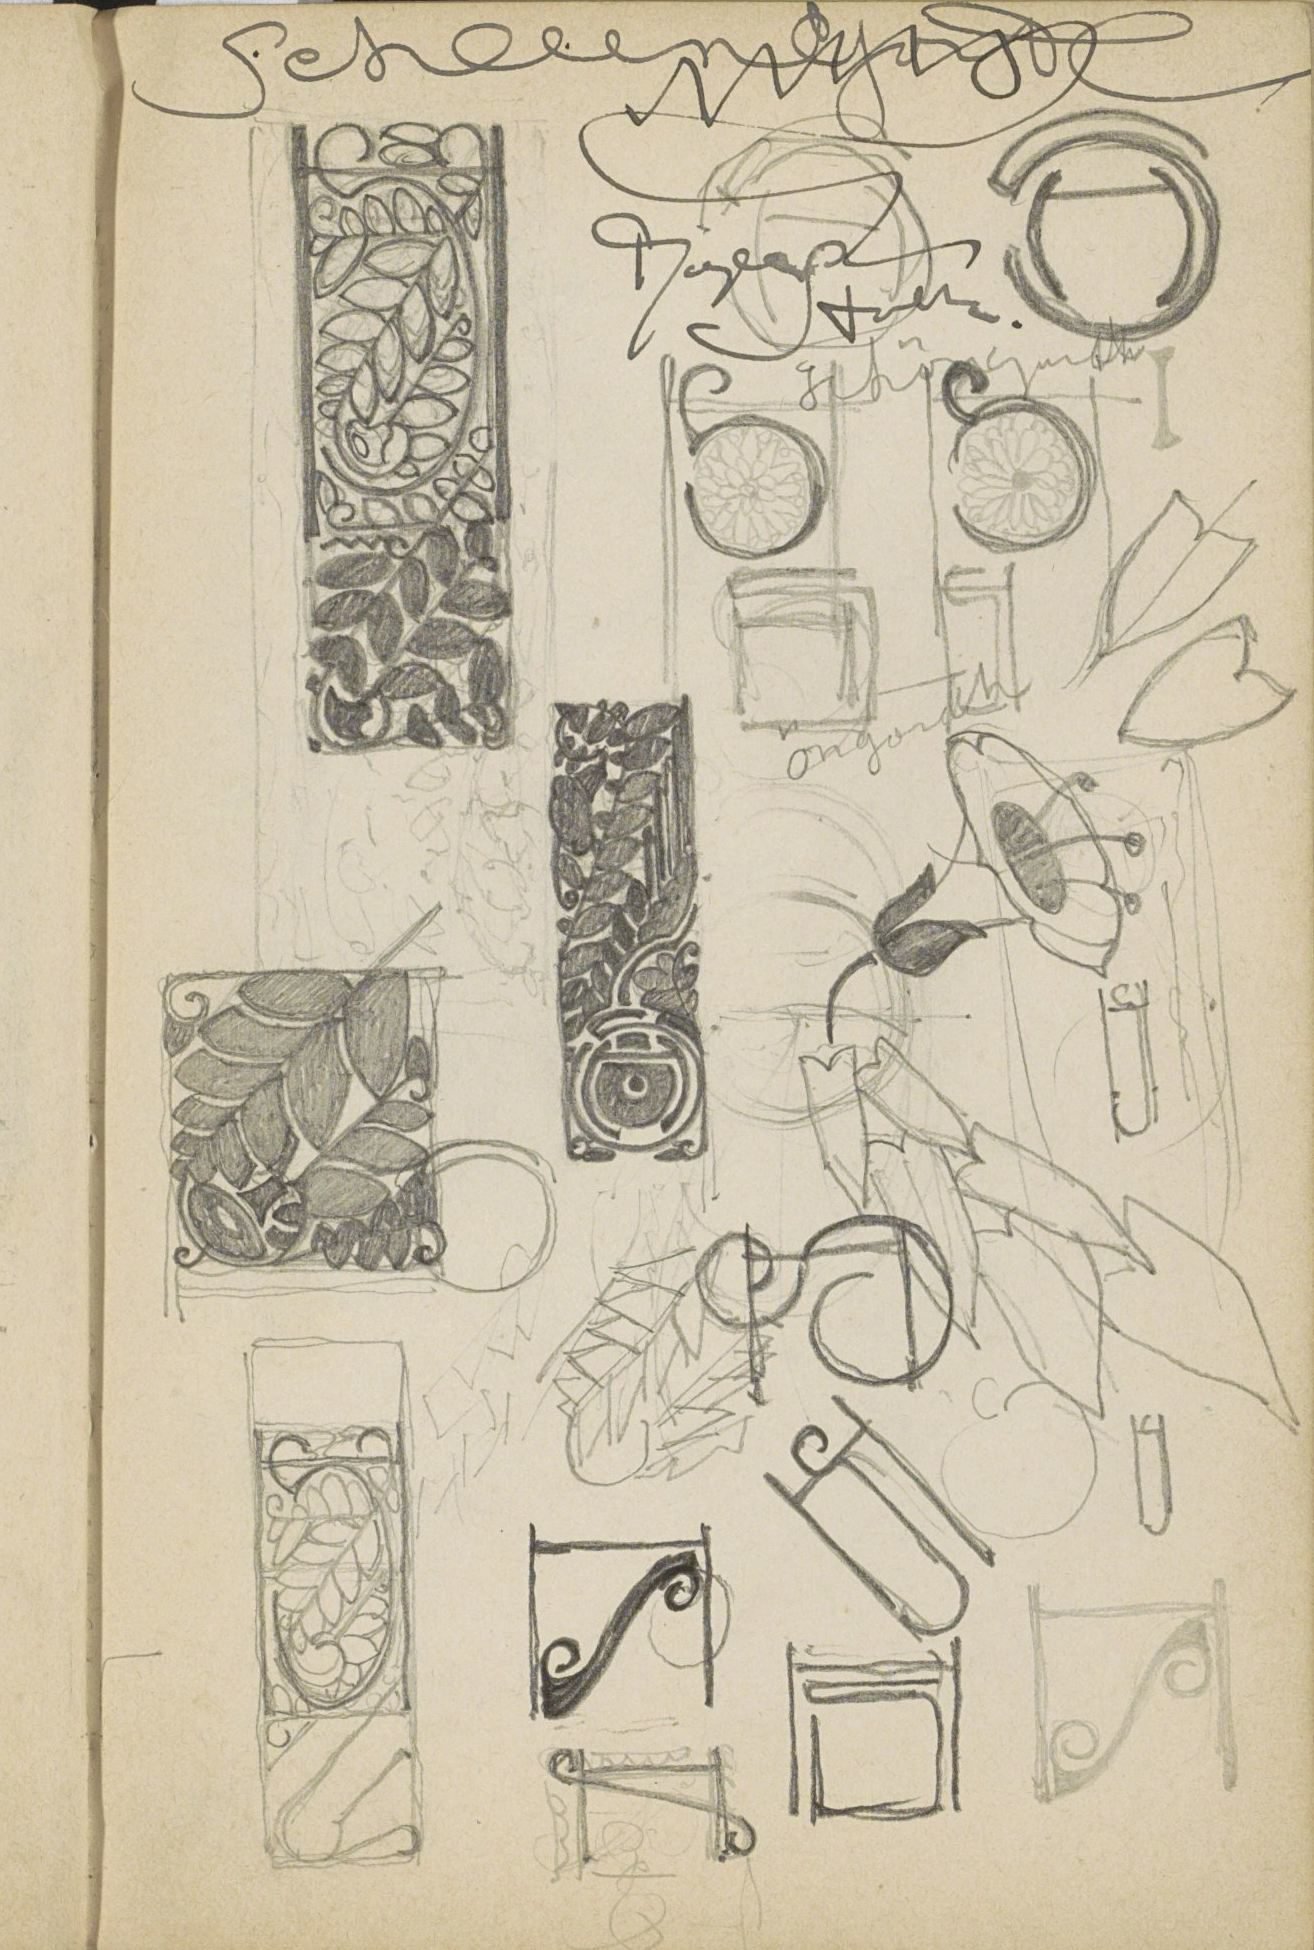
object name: sketchbook leaf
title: Ornamenten met bladmotieven, bloemen en letterontwerpen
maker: reijer stolk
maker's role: draughtsman, print maker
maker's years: 1896-1945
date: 1908-1919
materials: ink, paper, pencil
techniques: pen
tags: flowers, fancy letters, foliage, tendrils, branches ~ ornament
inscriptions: annotation: ‘Schee[...]/ [...]/ Reyer/ Stolk./ [...]’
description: Blad 12 recto uit een schetsboek met 33 bladen.